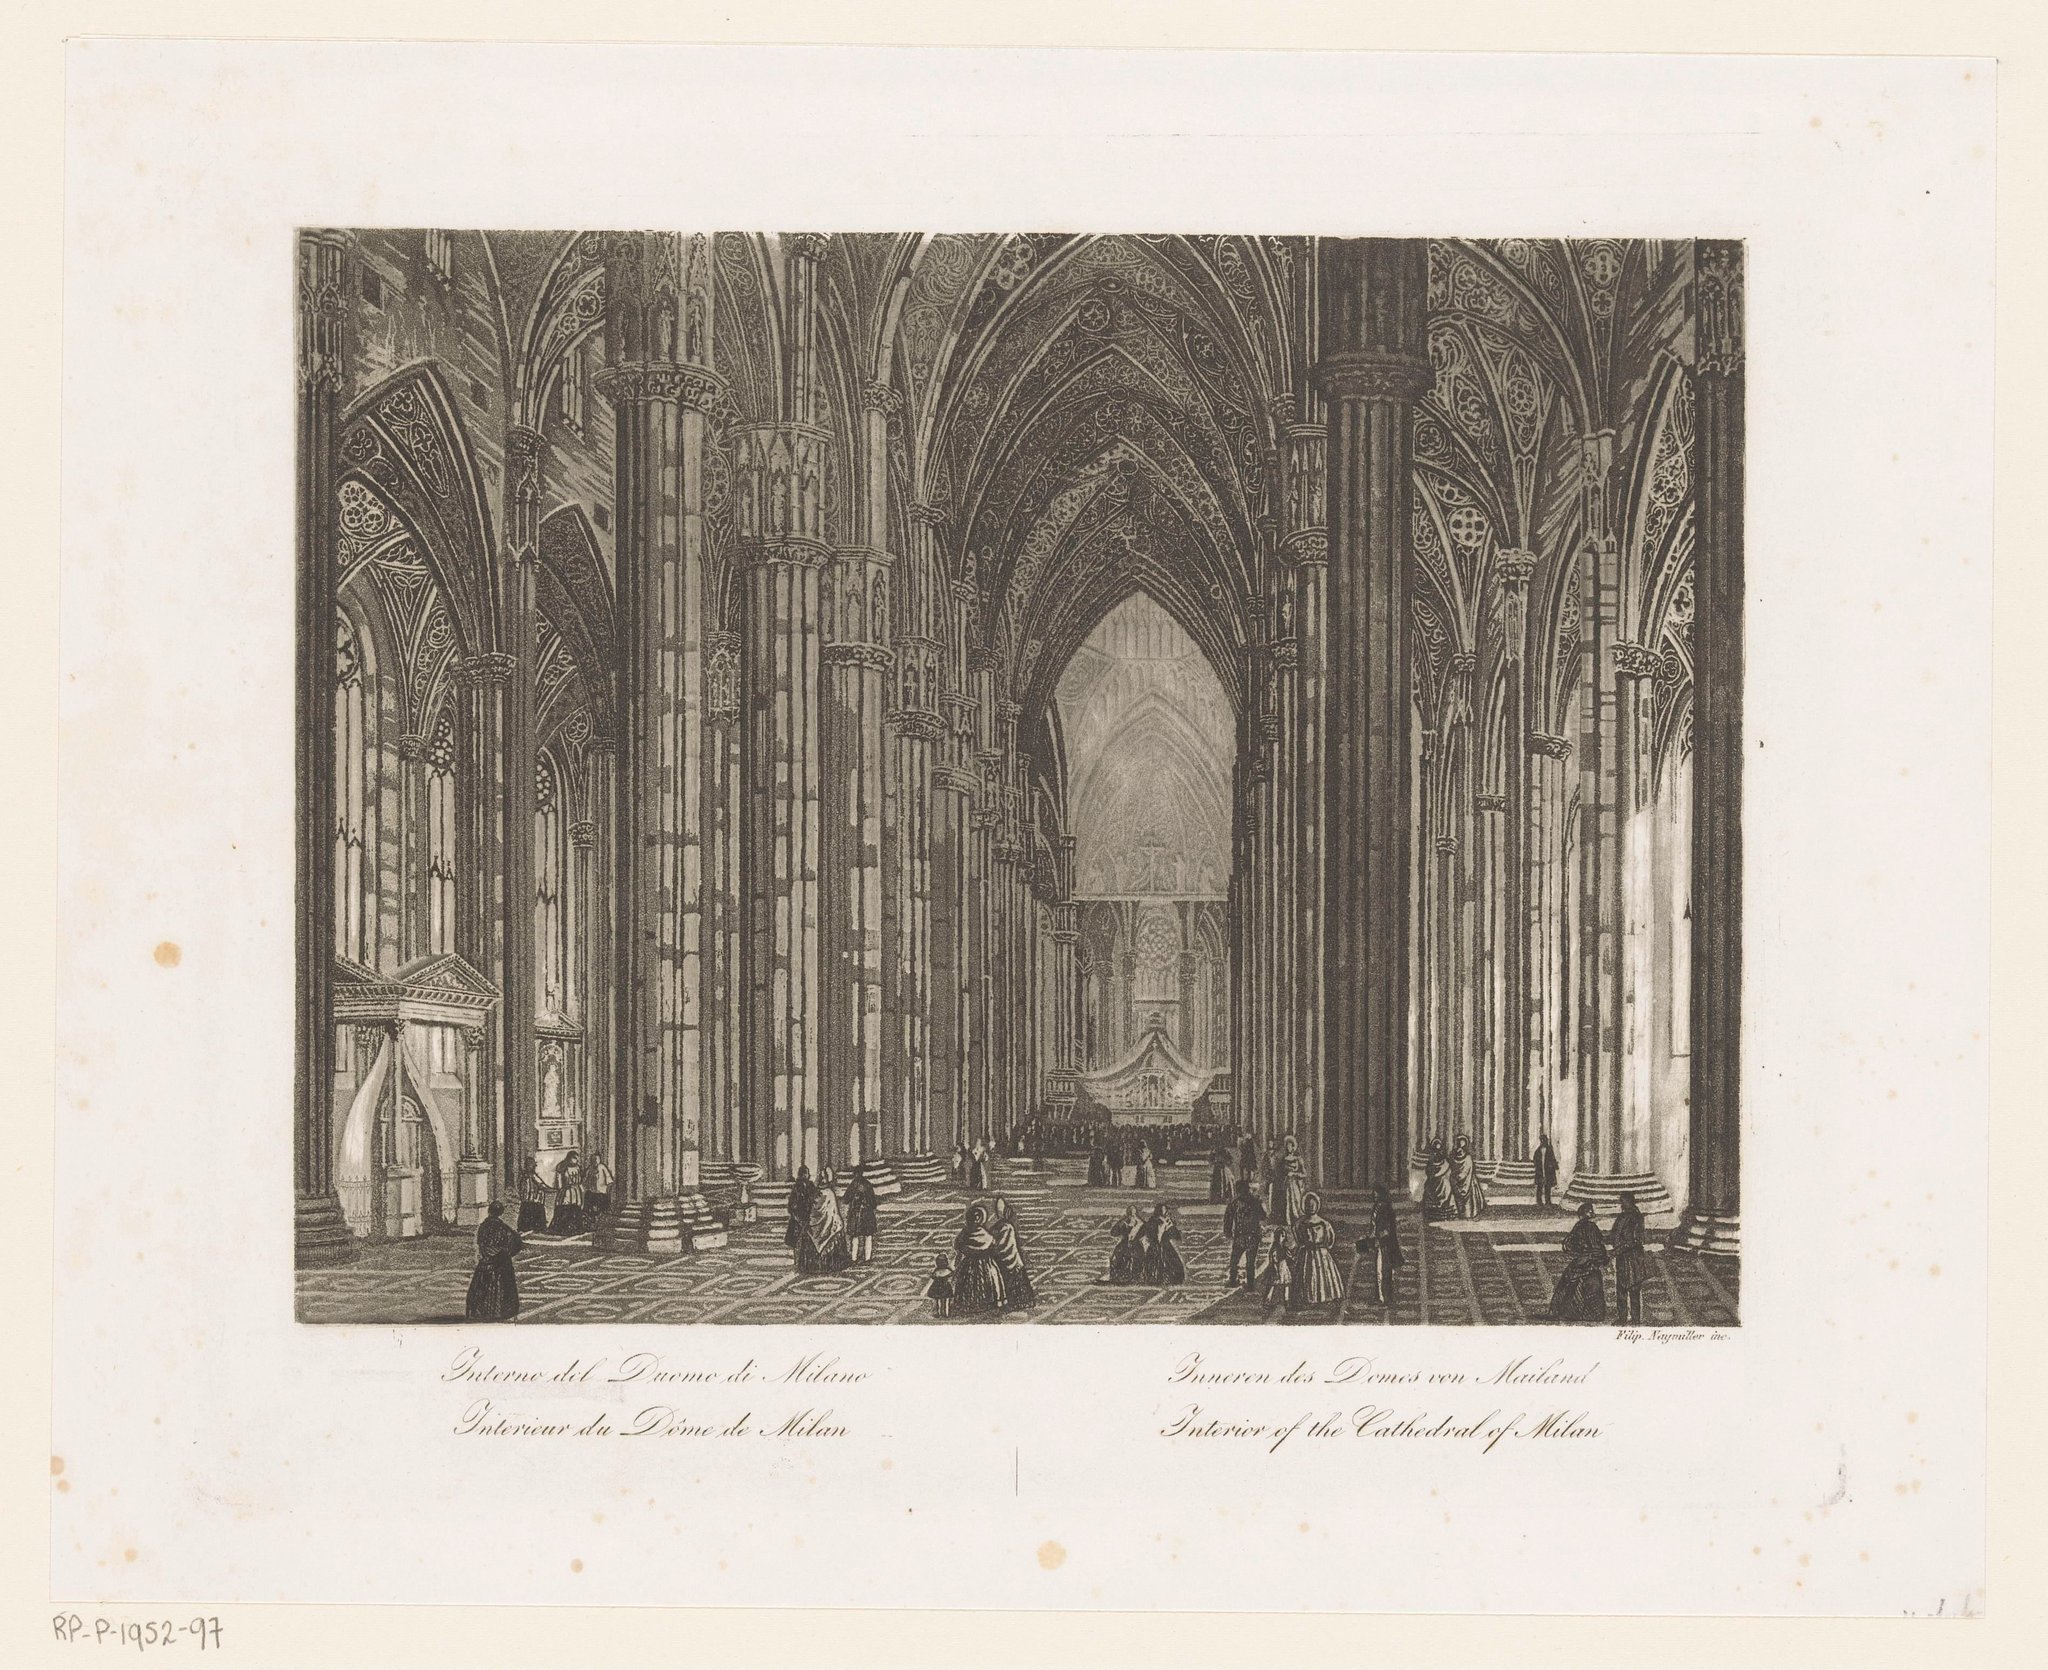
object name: print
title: Gezichten op de Dom van Milaan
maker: filippo naymiller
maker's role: print maker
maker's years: 1804-1863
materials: paper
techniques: aquatint, etching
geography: italy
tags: interior of church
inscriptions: collector's mark: Lugt 2228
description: Het interieur van de Dom van Milaan. Verscheidene figuren lopen rond in de kerk.